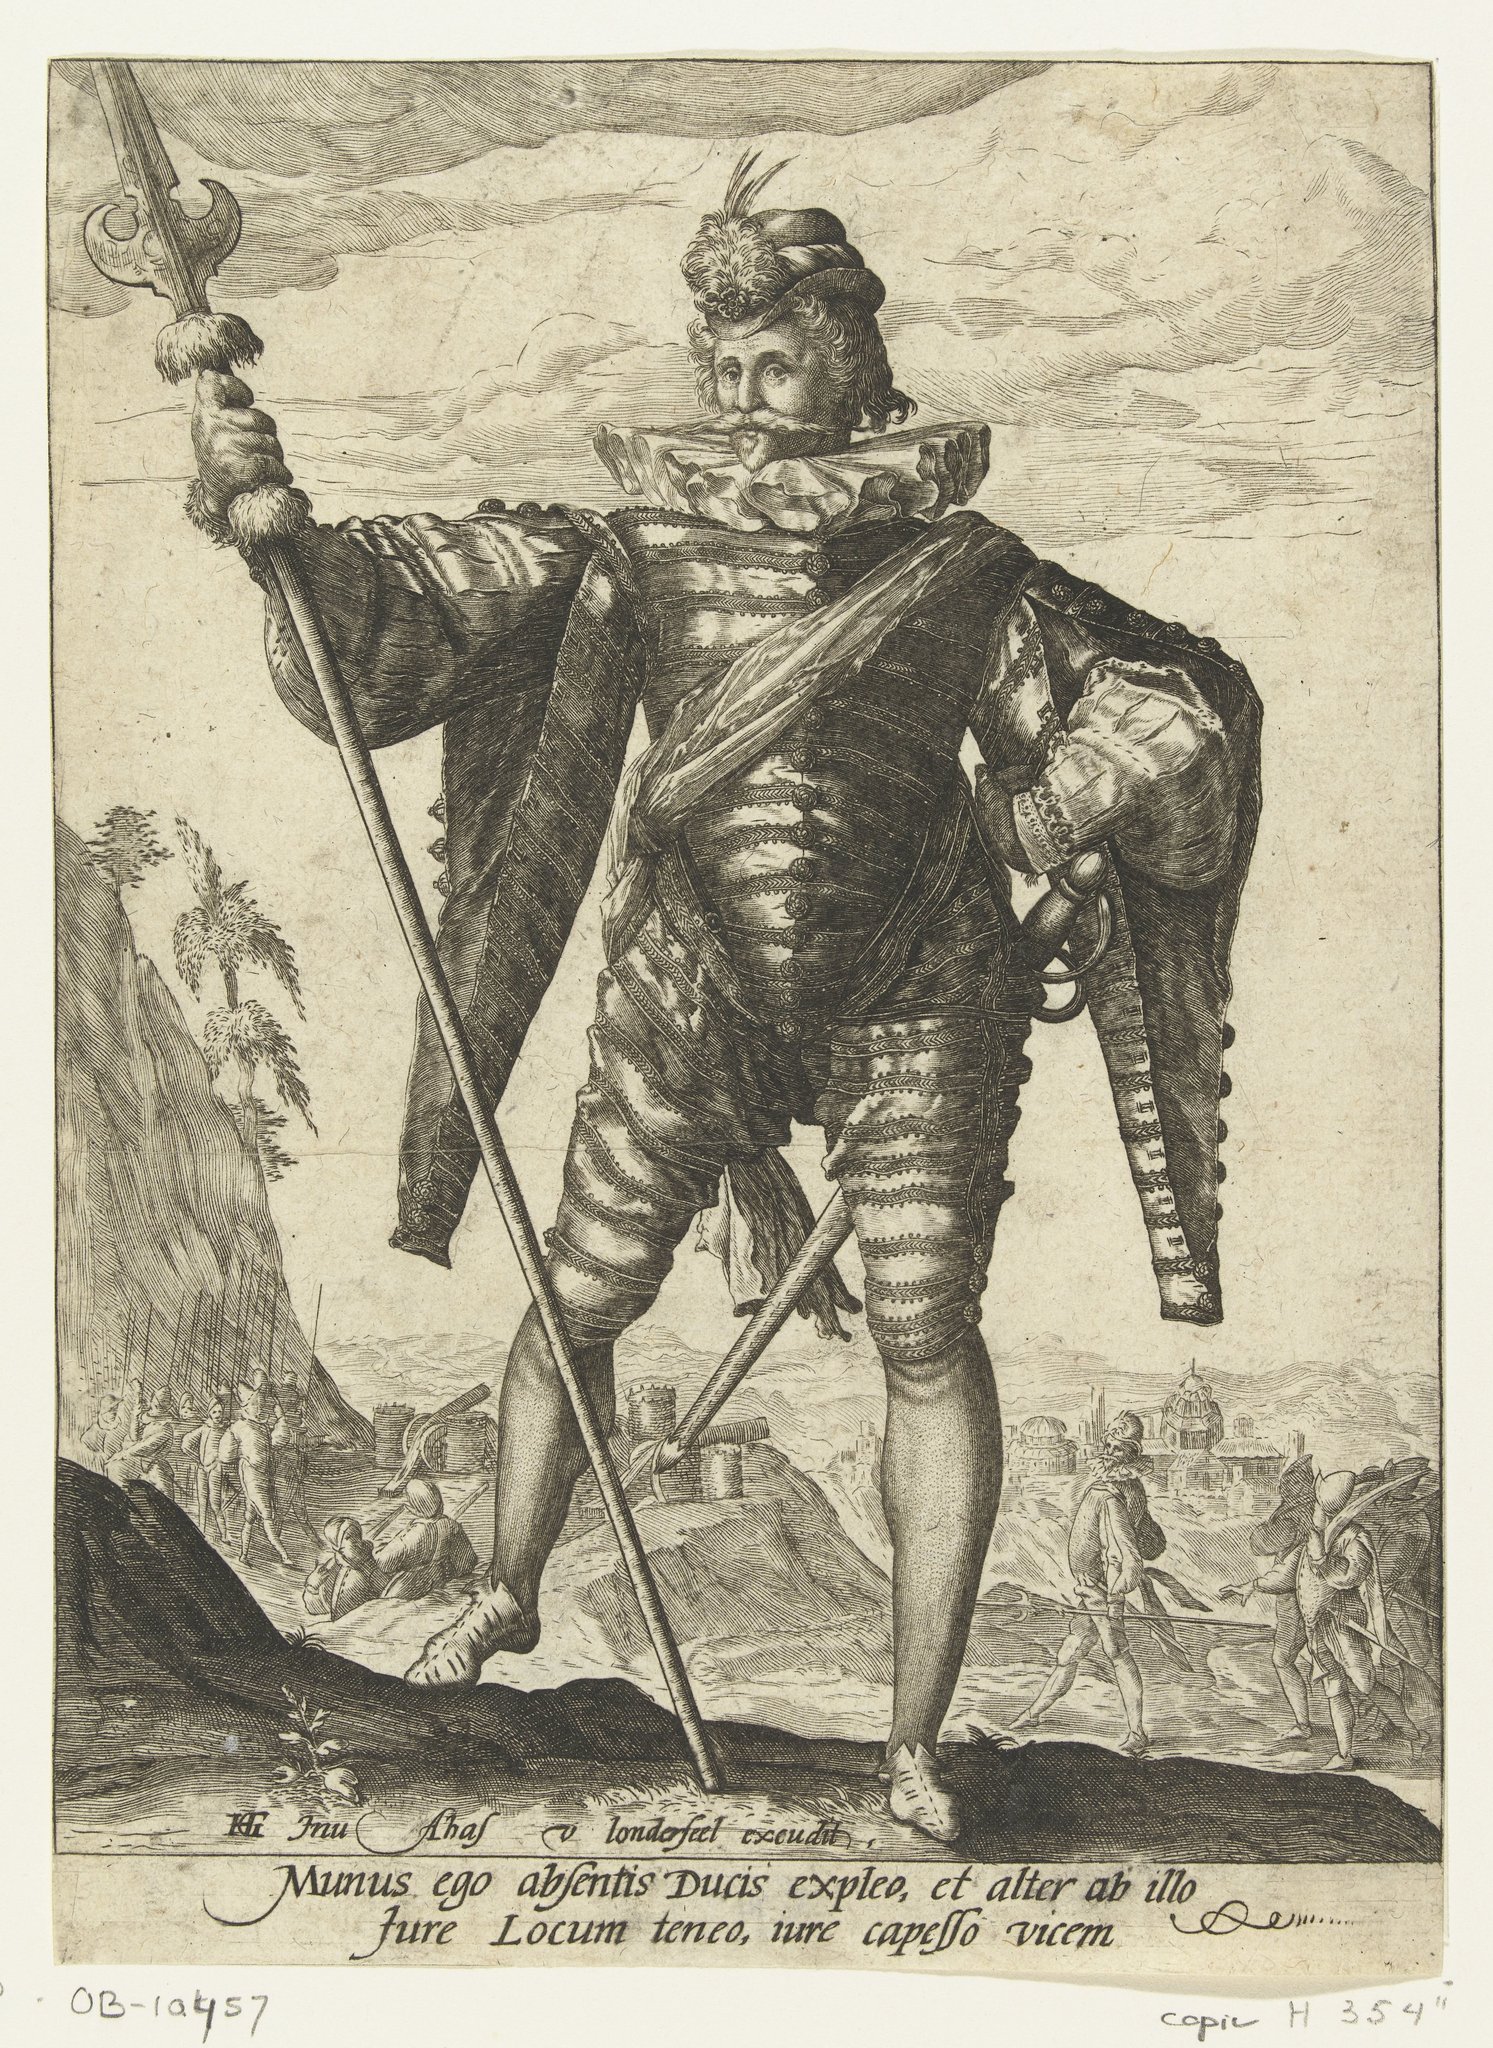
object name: print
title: Luitenant-kolonel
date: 1587-1595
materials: paper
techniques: engraving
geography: netherlands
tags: siege, position war, helved weapons, polearms (for striking, hacking, thrusting), officer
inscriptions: collector's mark: Lugt 2228a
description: Een man in militaire uitdossing (een luitenant-kolonel), ten voeten uit, een zwaard aan zijn gordel, een stokwapen (partizaan) in zijn rechterhand. Op de achtergrond een heuvelachtig landschap waarin een stad belegerd wordt. Onder de voorstelling twee regels tekst in Latijn. Deze prent is onderdeel van een serie van 12 prenten van militairen, ten voeten uit weergegeven tegen een landschappelijke achtergrond waarin krijgshandelingen verricht worden, en met een tweeregelig Latijns onderschrift.